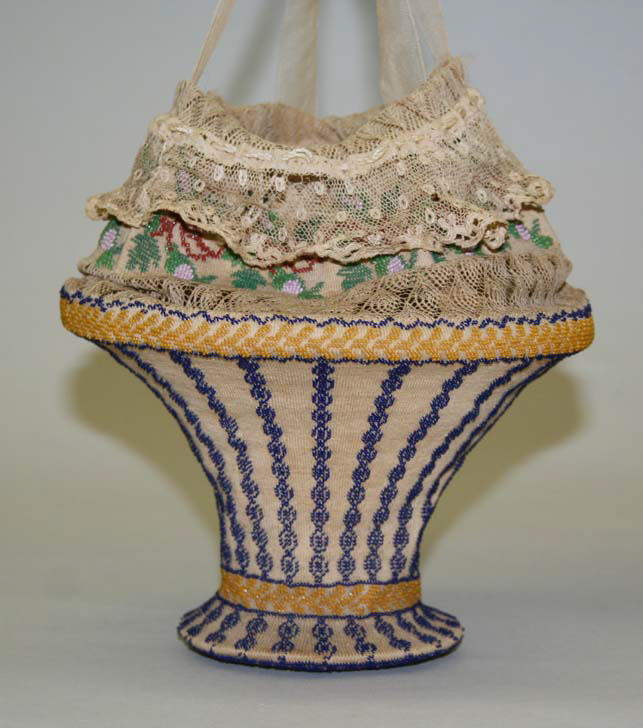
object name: purse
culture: dutch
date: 1810-1820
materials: cotton, glass